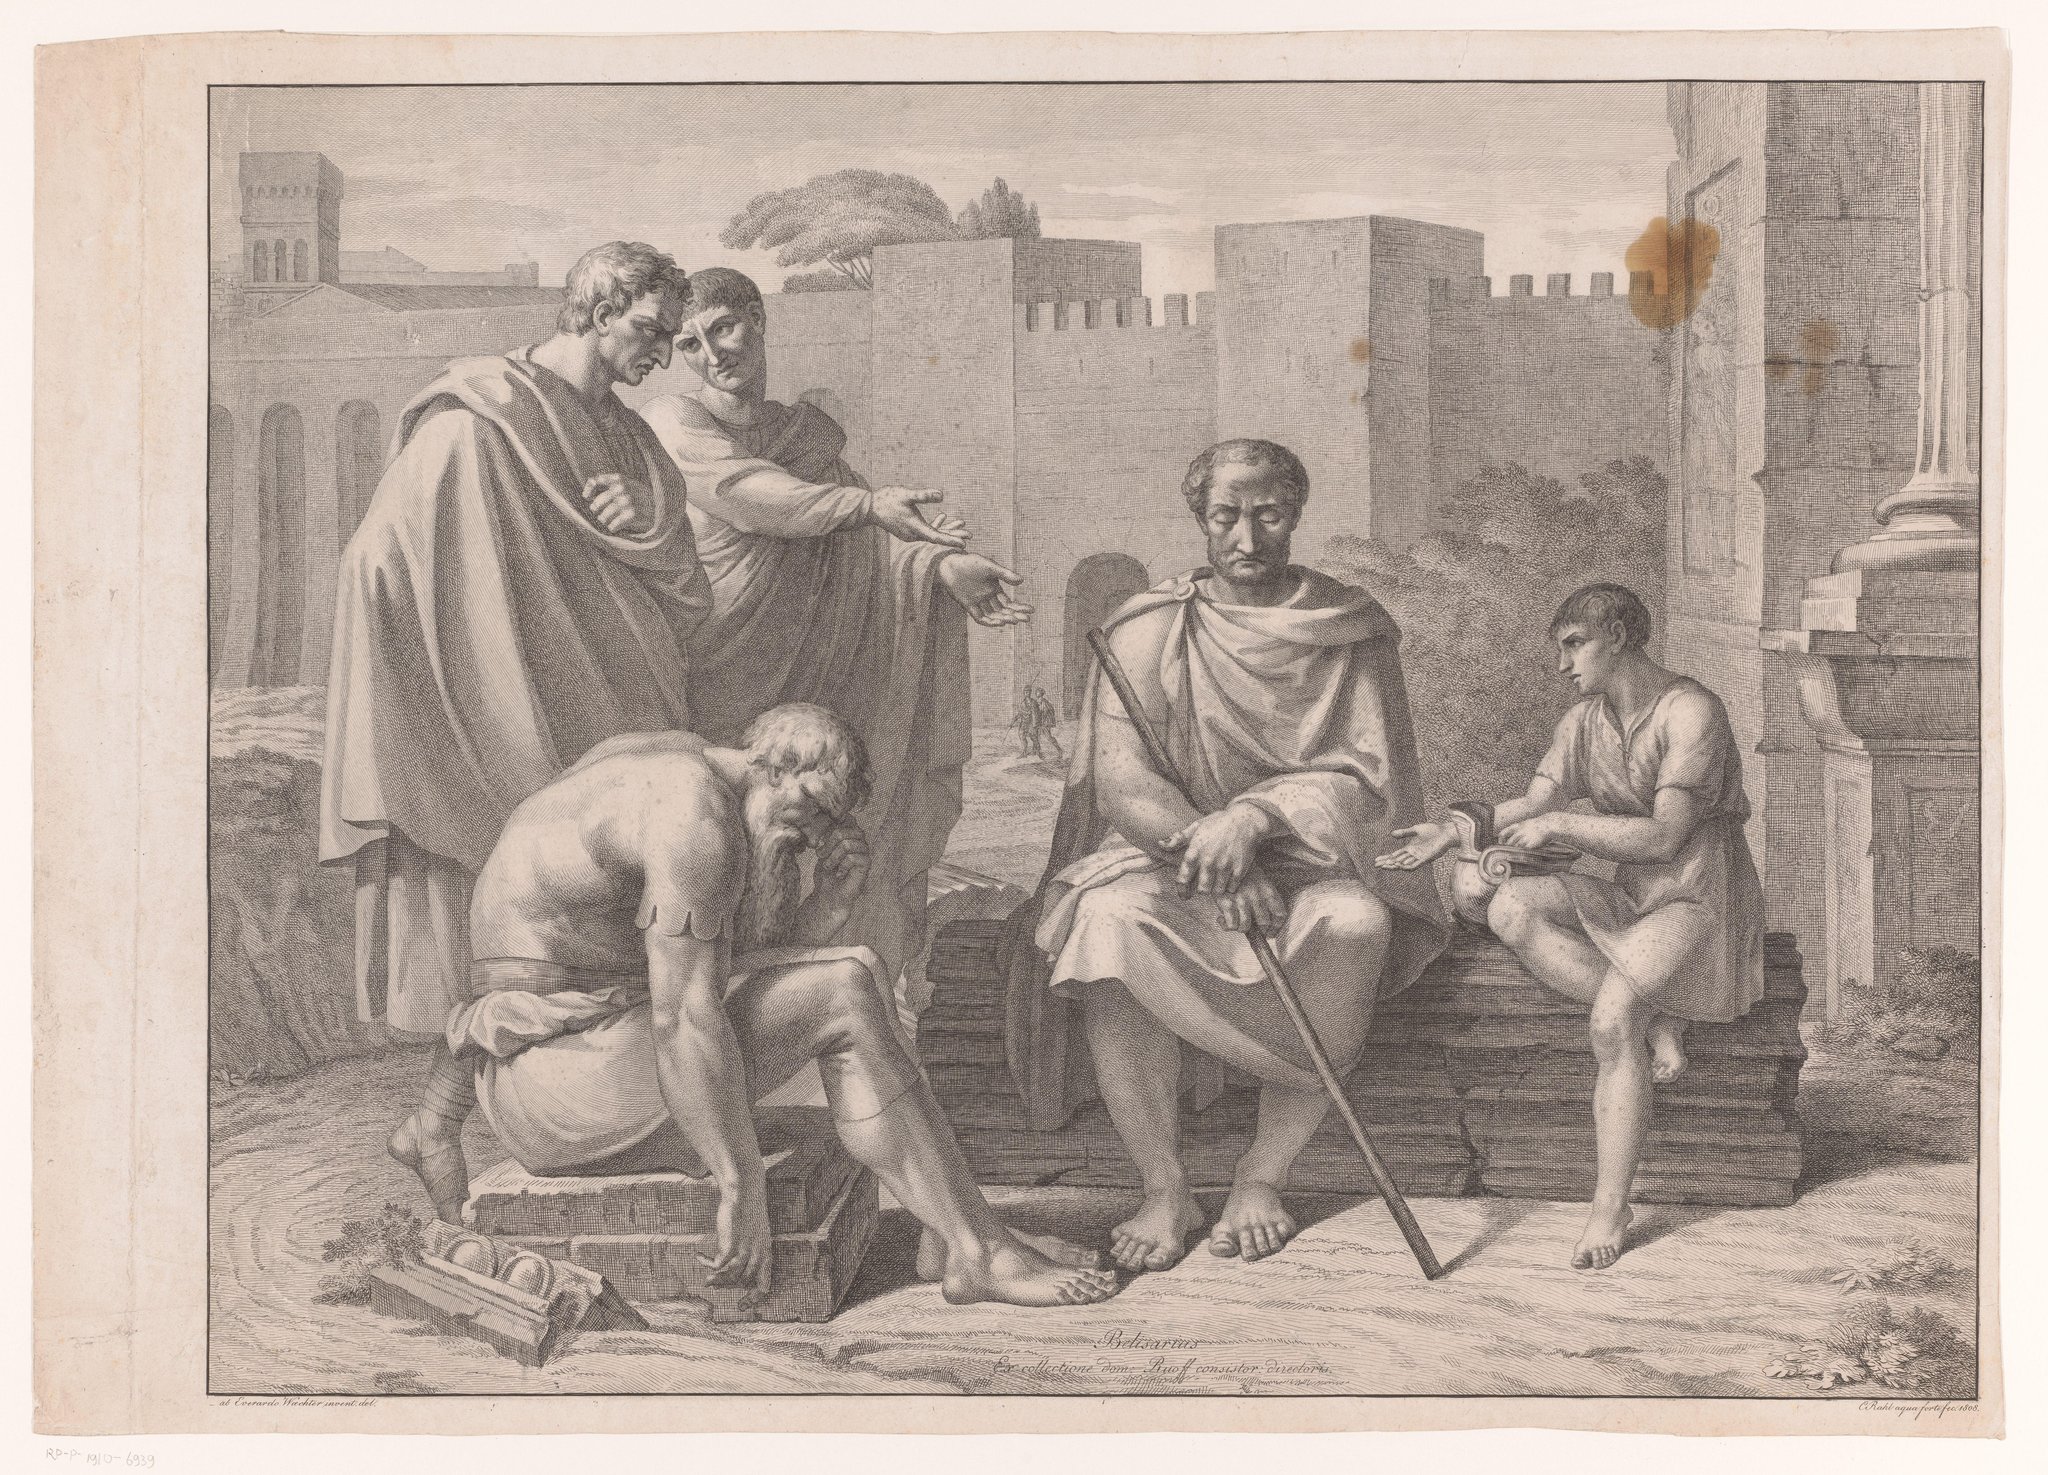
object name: print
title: Belisarius bedelt om een aalmoes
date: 1808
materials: paper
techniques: etching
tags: belisarius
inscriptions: collector's mark: Lugt 2228